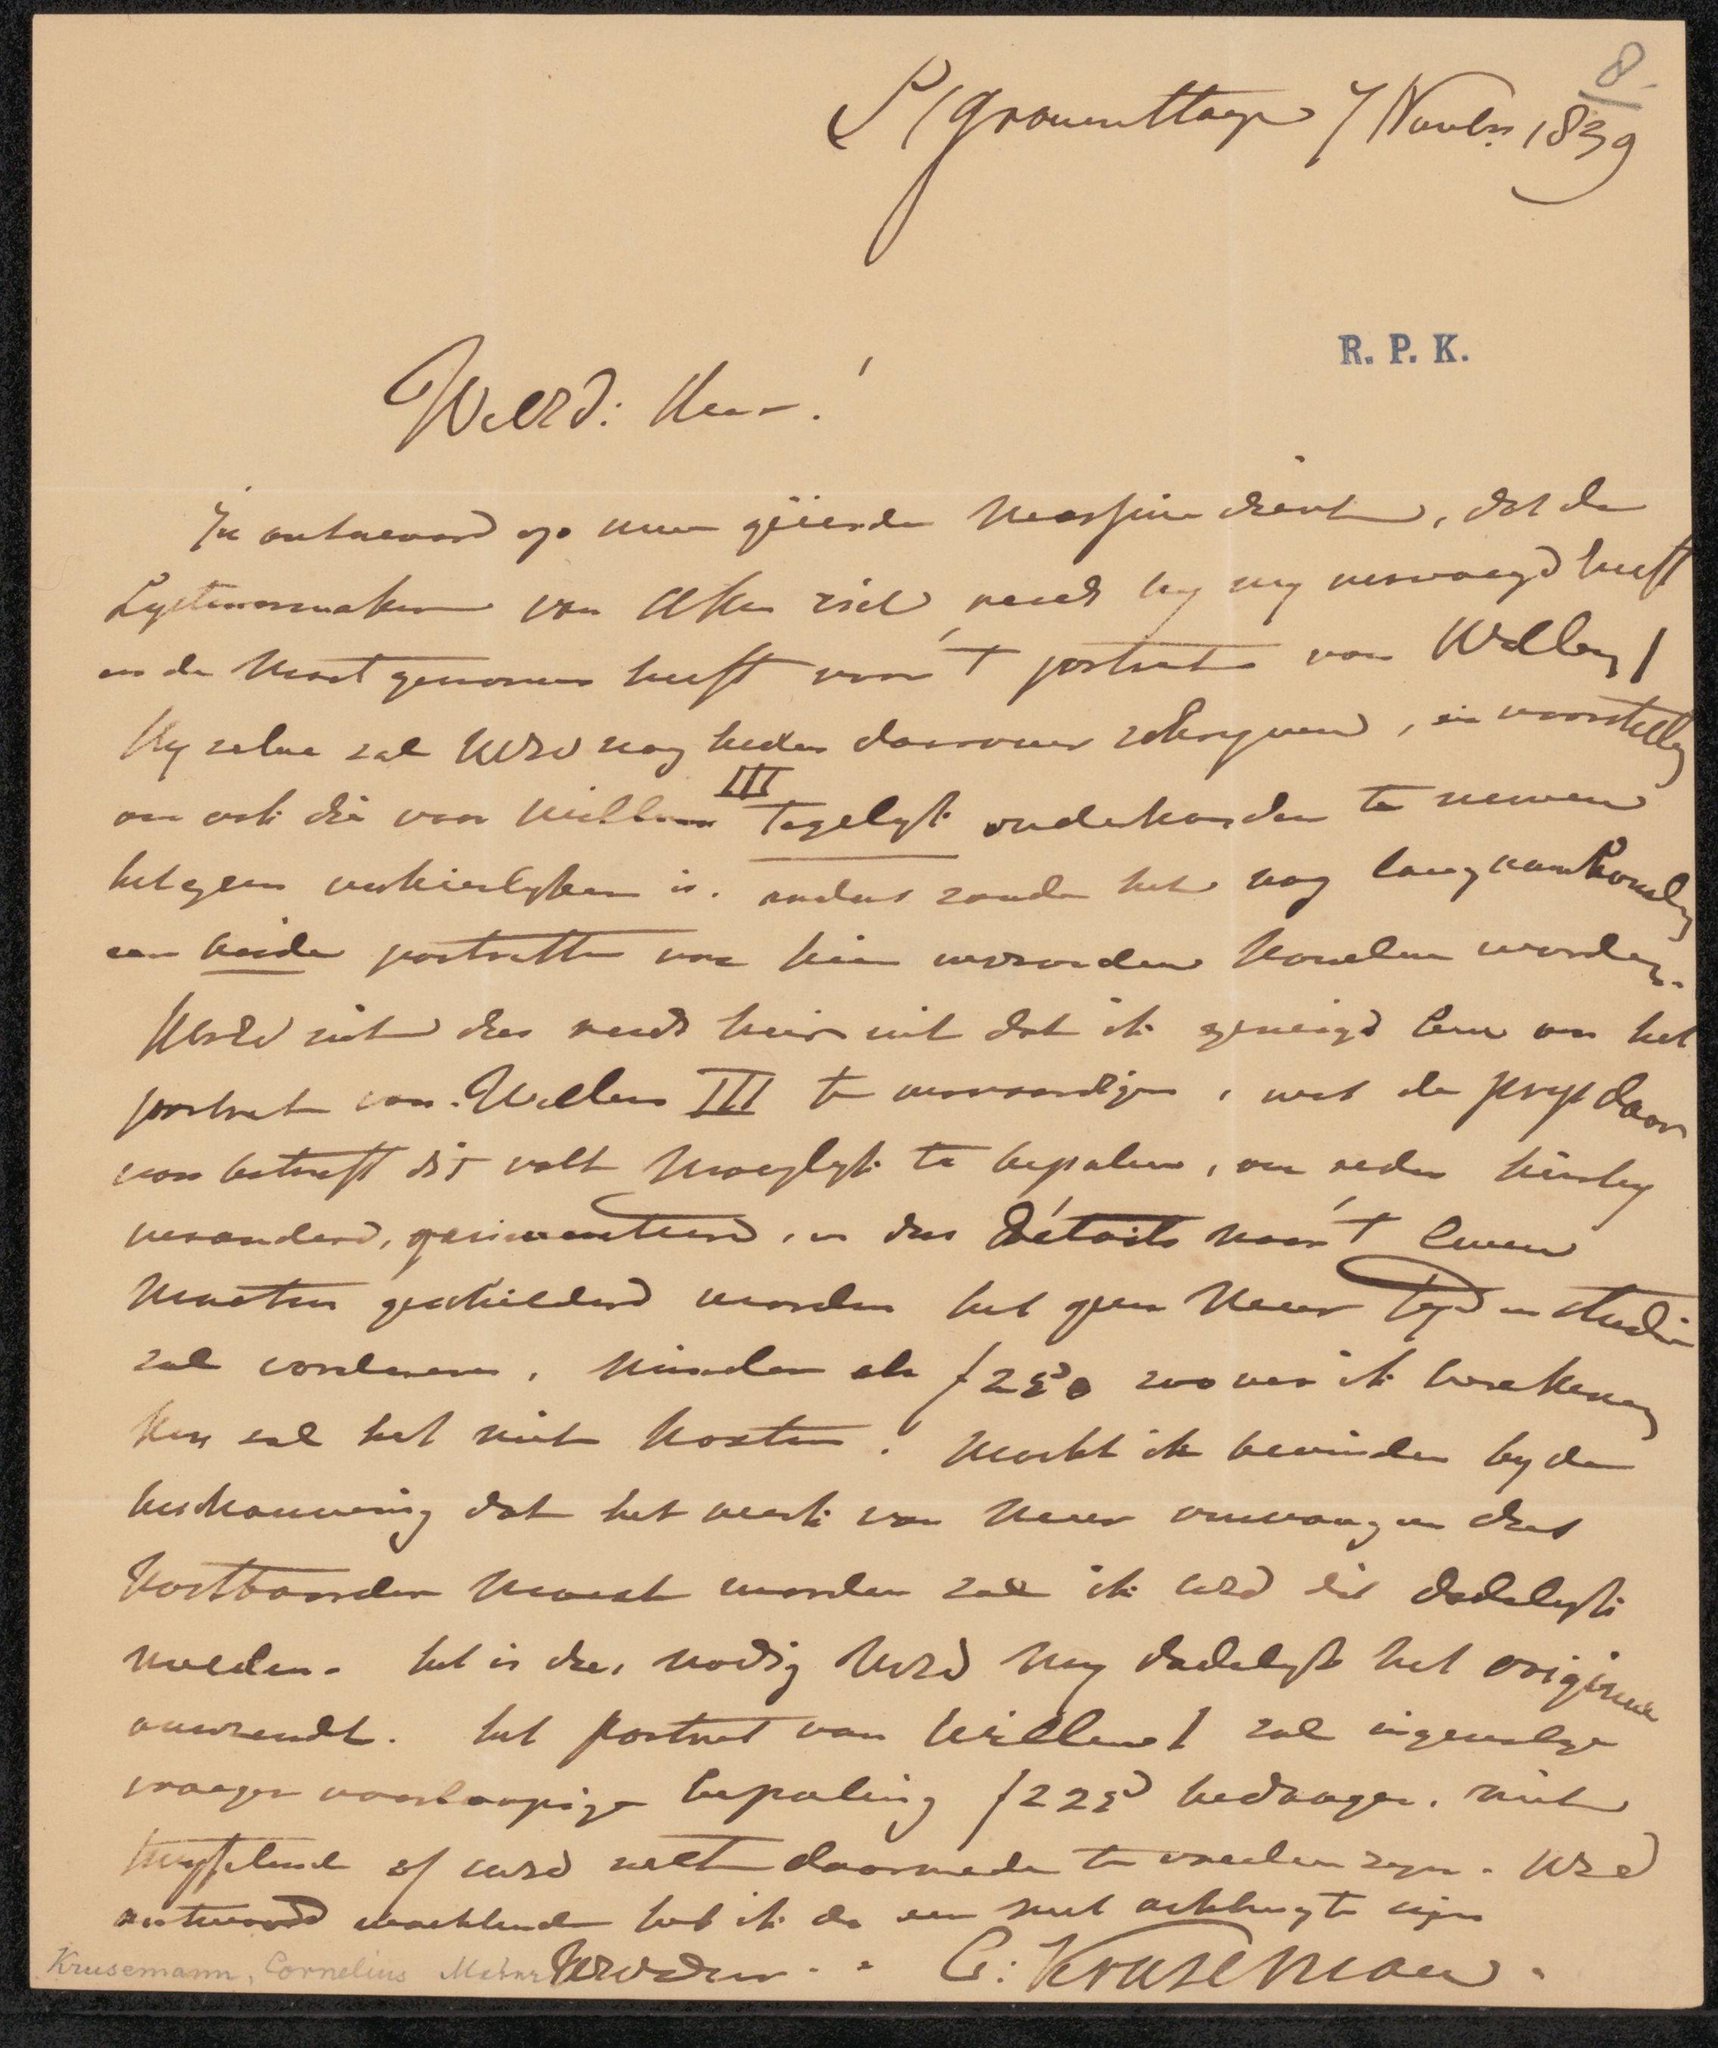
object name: letter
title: Brief aan F.C.R. Broers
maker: cornelis kruseman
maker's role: draughtsman, painter, print maker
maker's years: 1797-1857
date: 1839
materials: ink, paper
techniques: pen, writing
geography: the hague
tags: berlin, william i of the netherlands, brussels, willem iii (koning der nederlanden), historical persons (portraits and scenes from the life), money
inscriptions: collector's mark: Lugt 2233